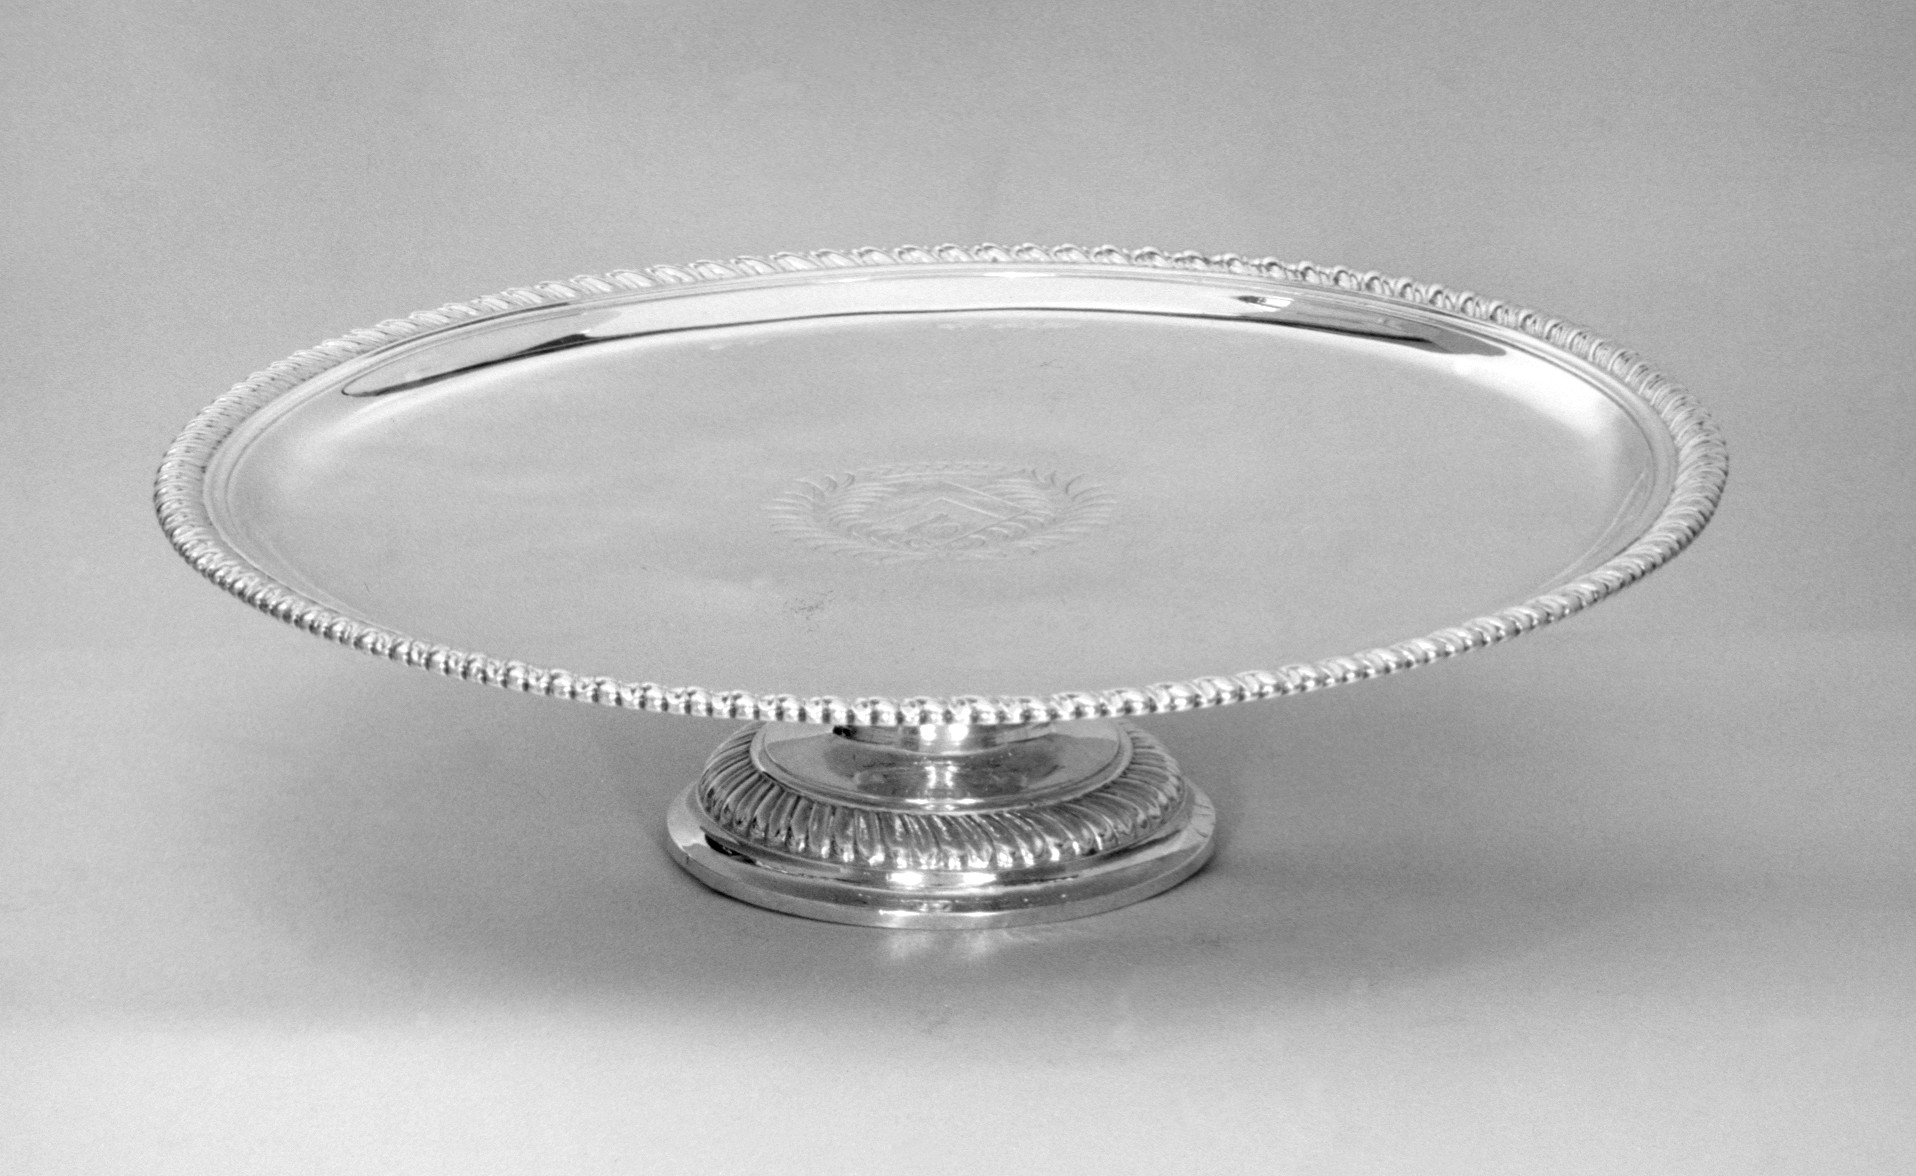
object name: tazza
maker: pierre platel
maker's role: maker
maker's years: 1699-1719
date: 1710-1711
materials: silver